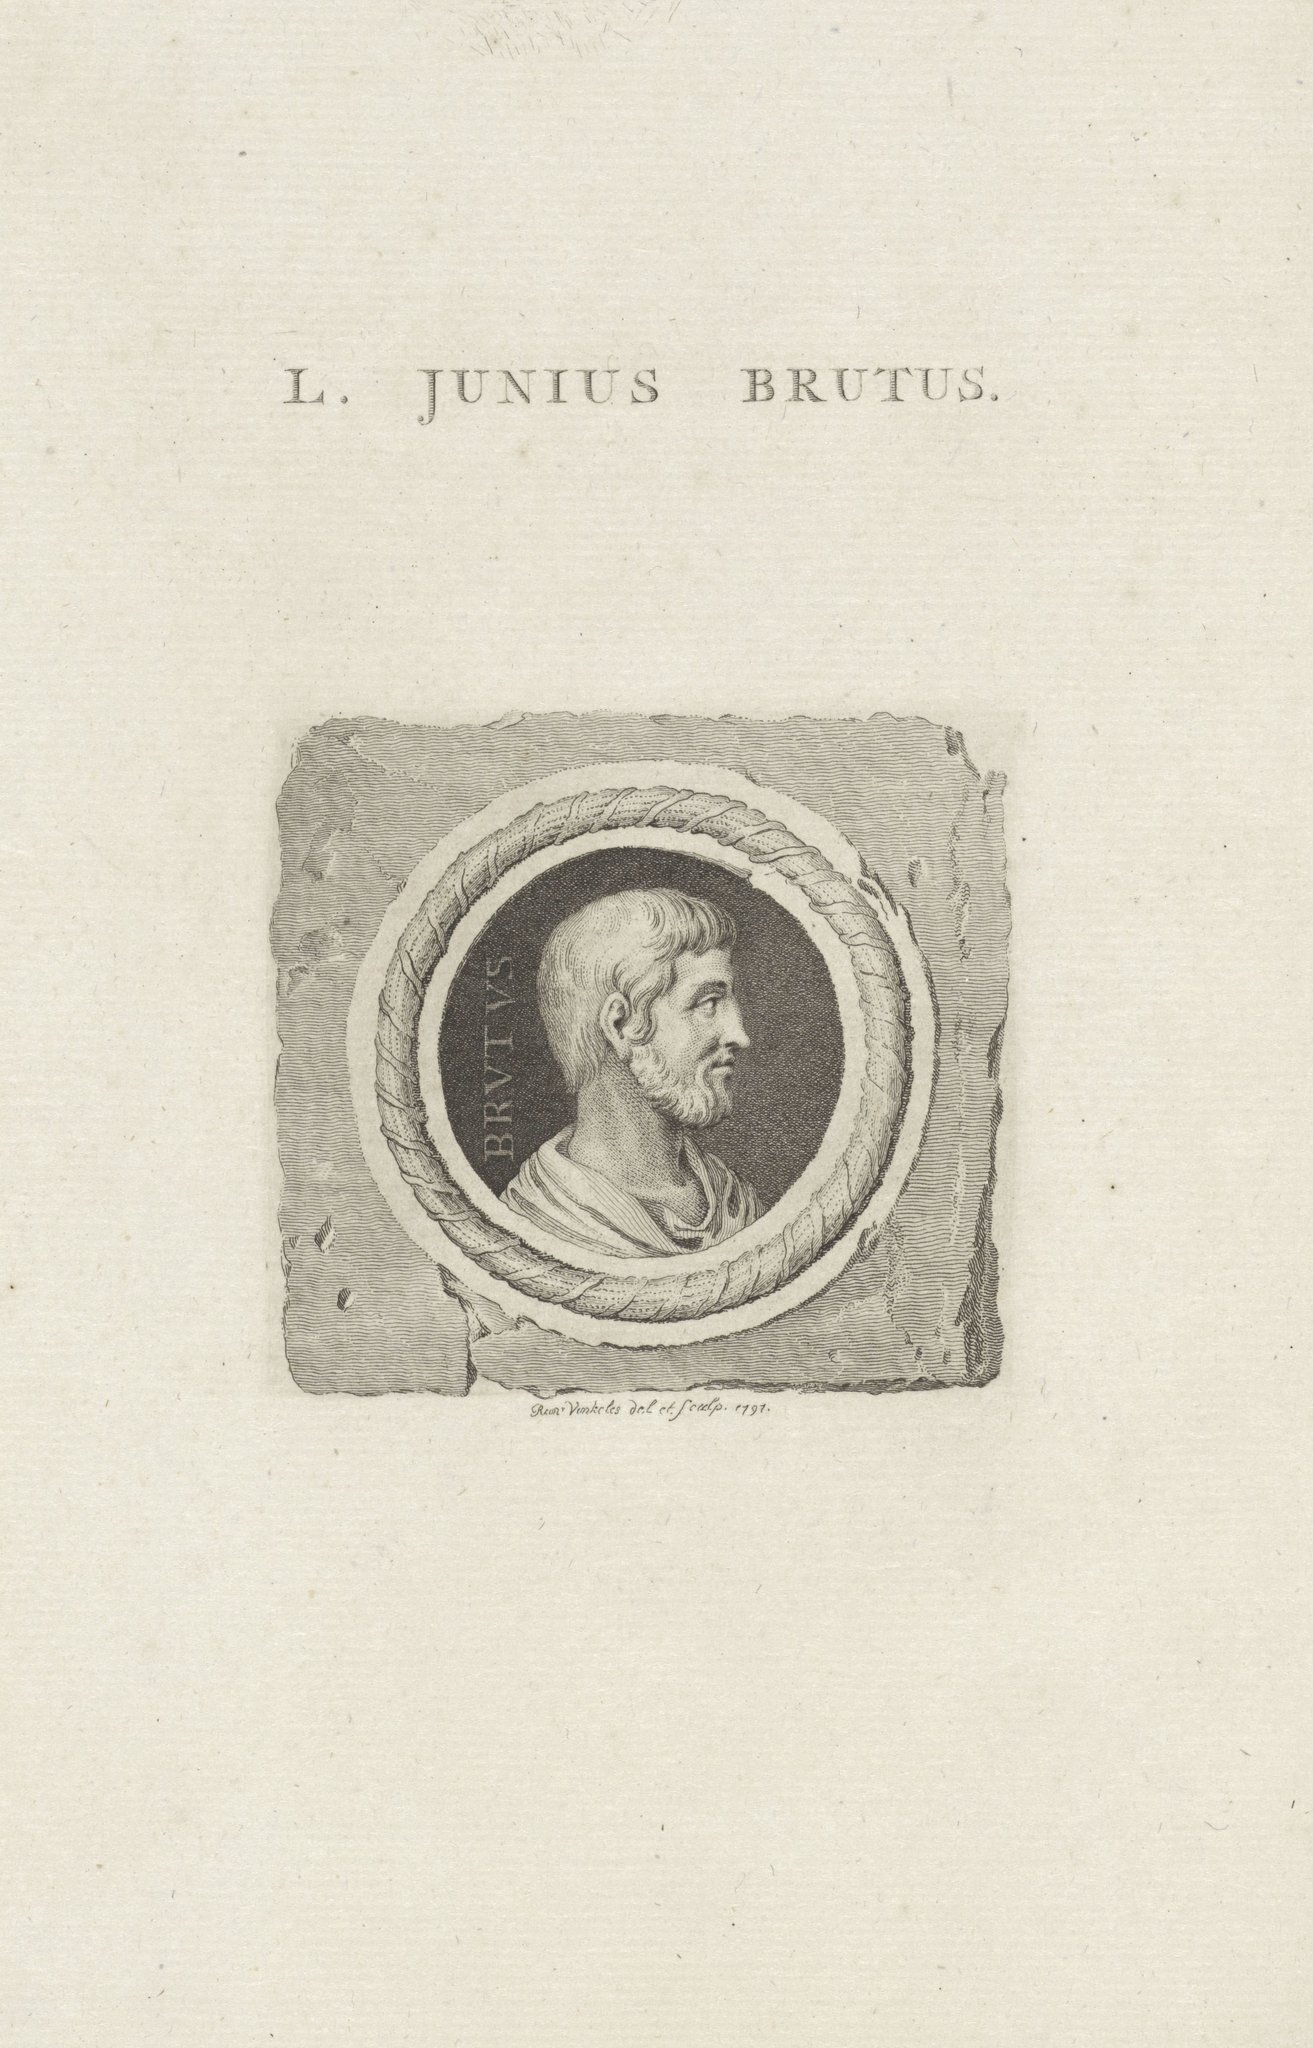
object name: book illustration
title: Steen met een medaillon van de Romeinse consul Lucius Junius Brutus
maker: reinier vinkeles (i)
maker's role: draughtsman, print maker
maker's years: 1741-1816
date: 1797-1798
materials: paper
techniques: etching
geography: amsterdam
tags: (story of) l. junius brutus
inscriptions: collector's mark: Lugt 240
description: Gebruikt als boekillustratie in: L. Junius Brutus. Haarlem: A. Loosjes, 1797 en Adriaan Pietersz. Loosjes, Romeinsche antieken van vrijheids en vaderlands-liefde. Haarlem: A. Loosjes, 1798.